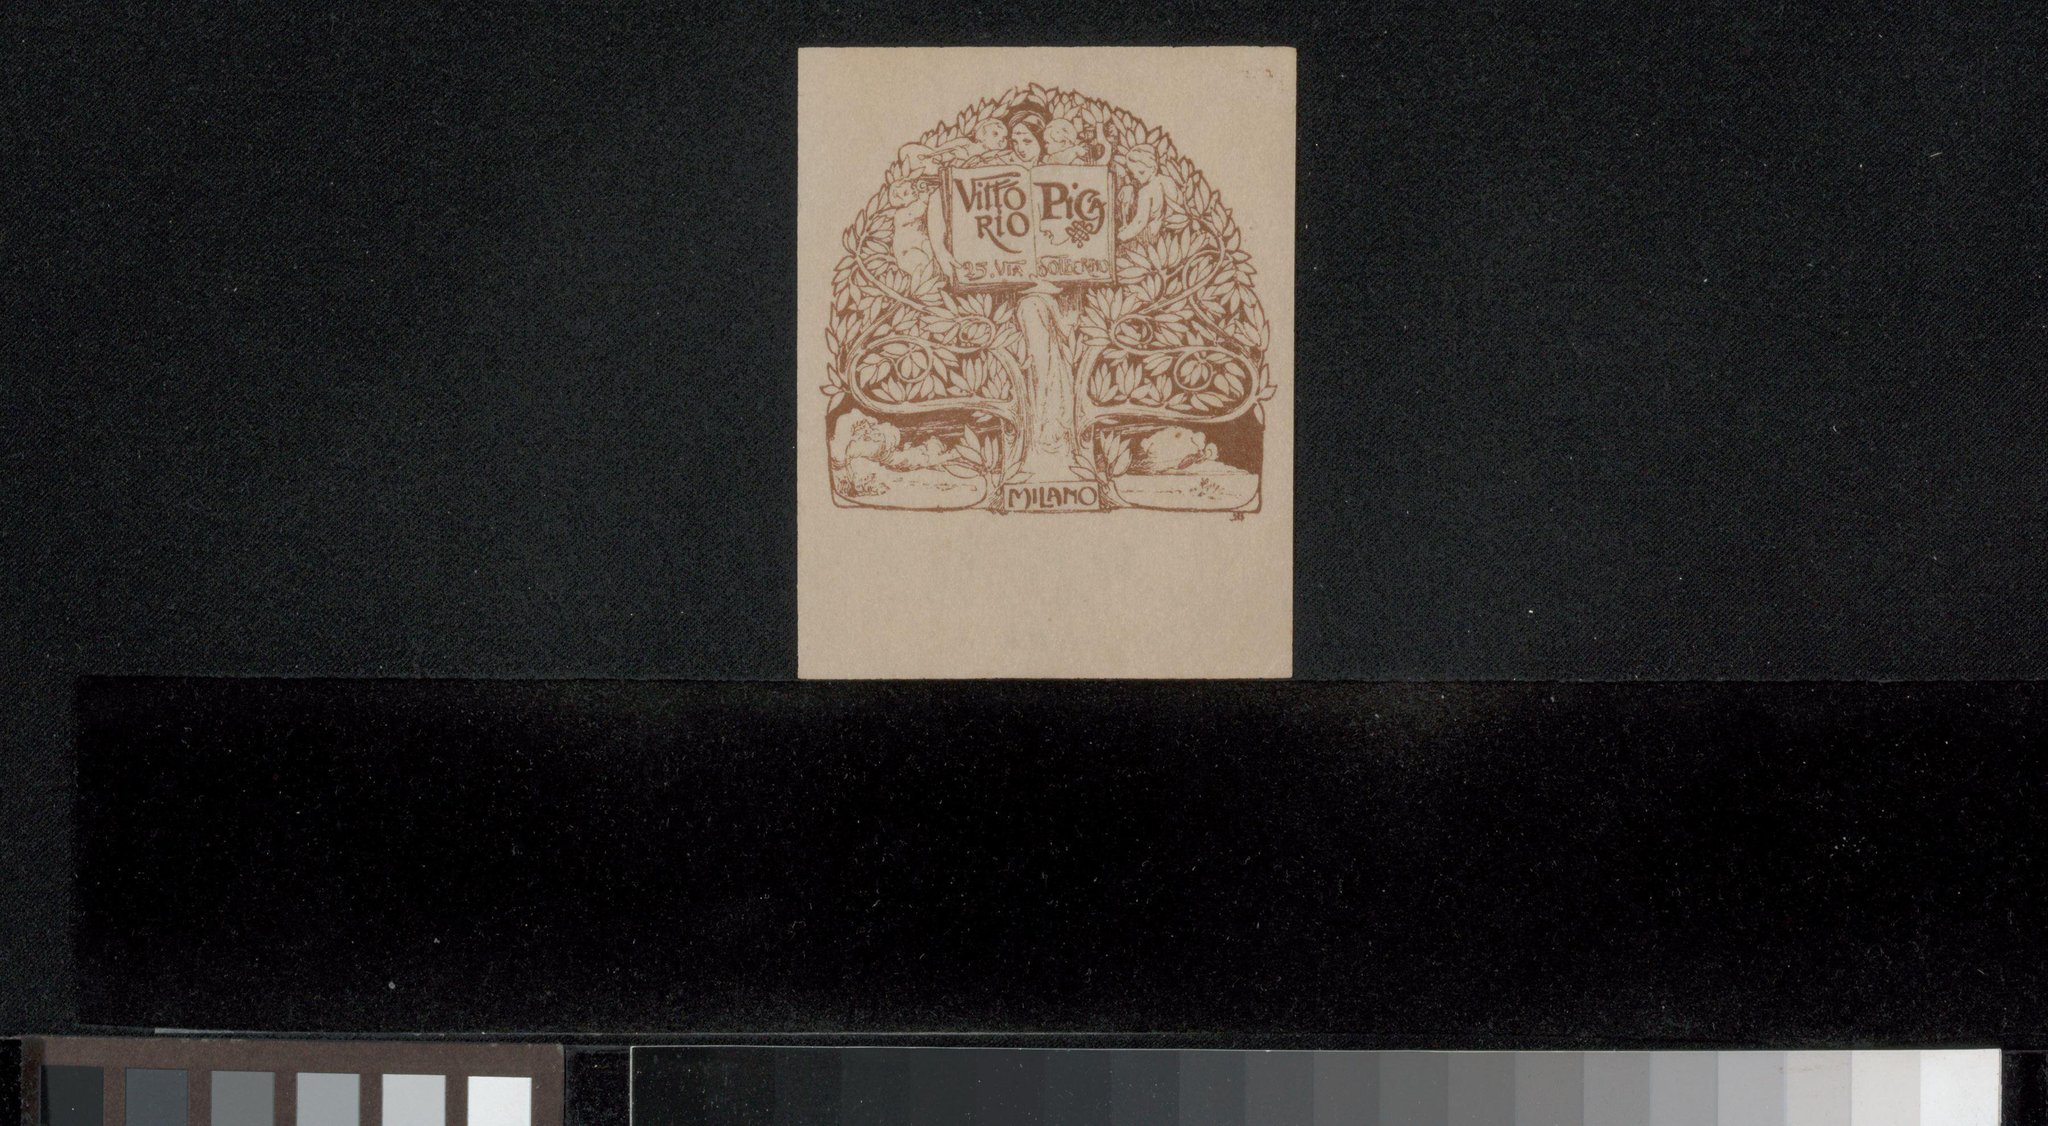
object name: business card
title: Adreskaart uit archief Philip Zilcken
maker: vittorio pica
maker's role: criticus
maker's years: 1864-1930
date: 1883-1930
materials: paper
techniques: printing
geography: milan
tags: the hague, painter, draughtsman, philip zilcken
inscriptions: collector's mark: ‘RPK’